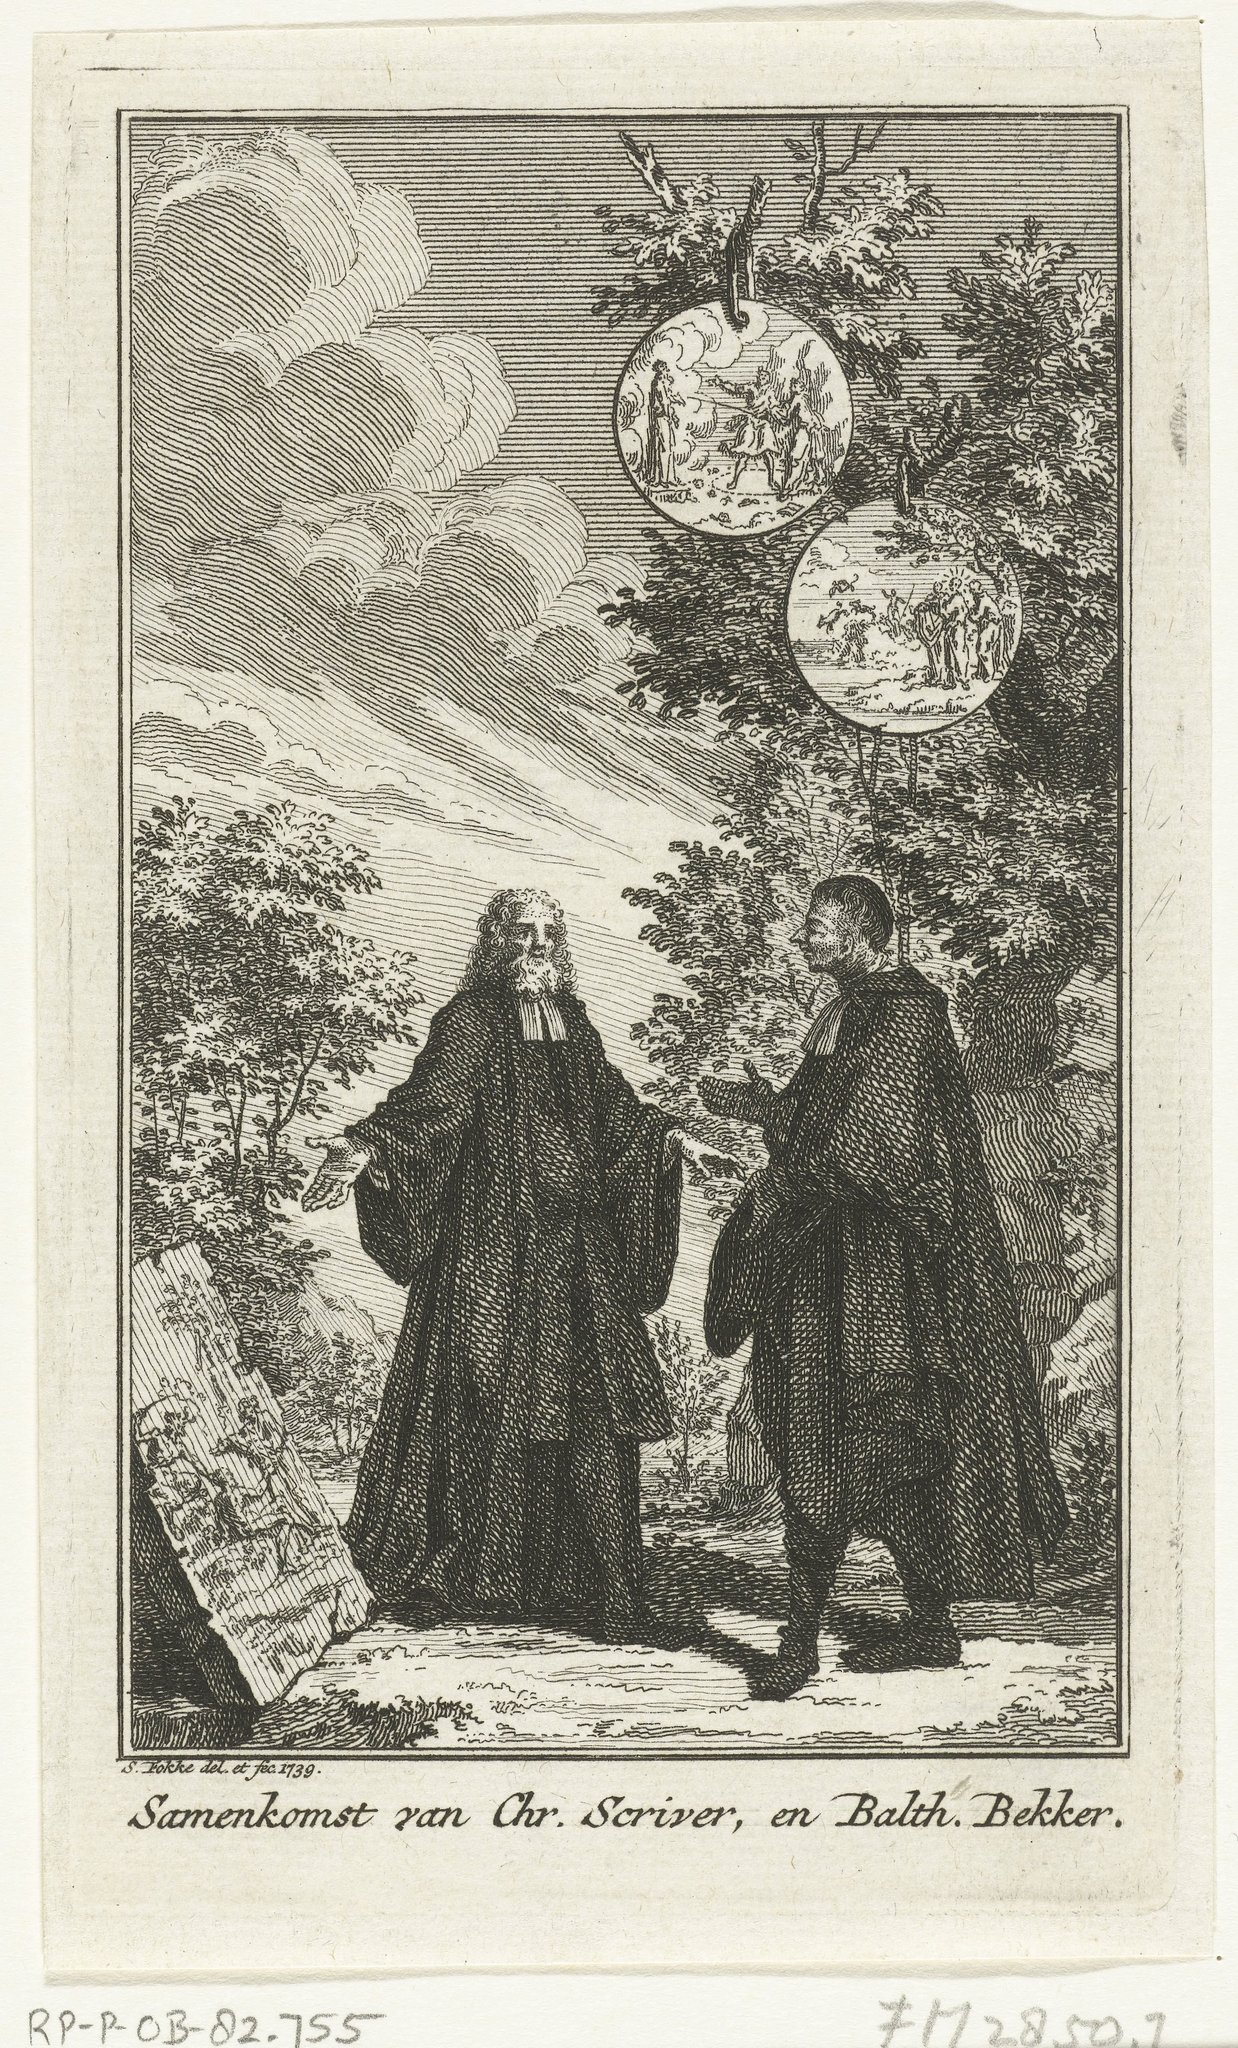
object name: print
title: Samenkomst van Christiaan Scriver en Balthasar Bekker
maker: simon fokke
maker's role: draughtsman, print maker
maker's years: 1712-1784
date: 1739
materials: paper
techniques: etching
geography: northern netherlands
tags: amsterdam, balthasar bekker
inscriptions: date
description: De ontmoeting in het dodenrijk tussen de geleerden Christiaan Scriver en Balthasar Bekker. Onderdeel van een groep bladen in verband met de uitgave in 1691 van het boek: De betoverde weereld, van Balthasar Bekker.